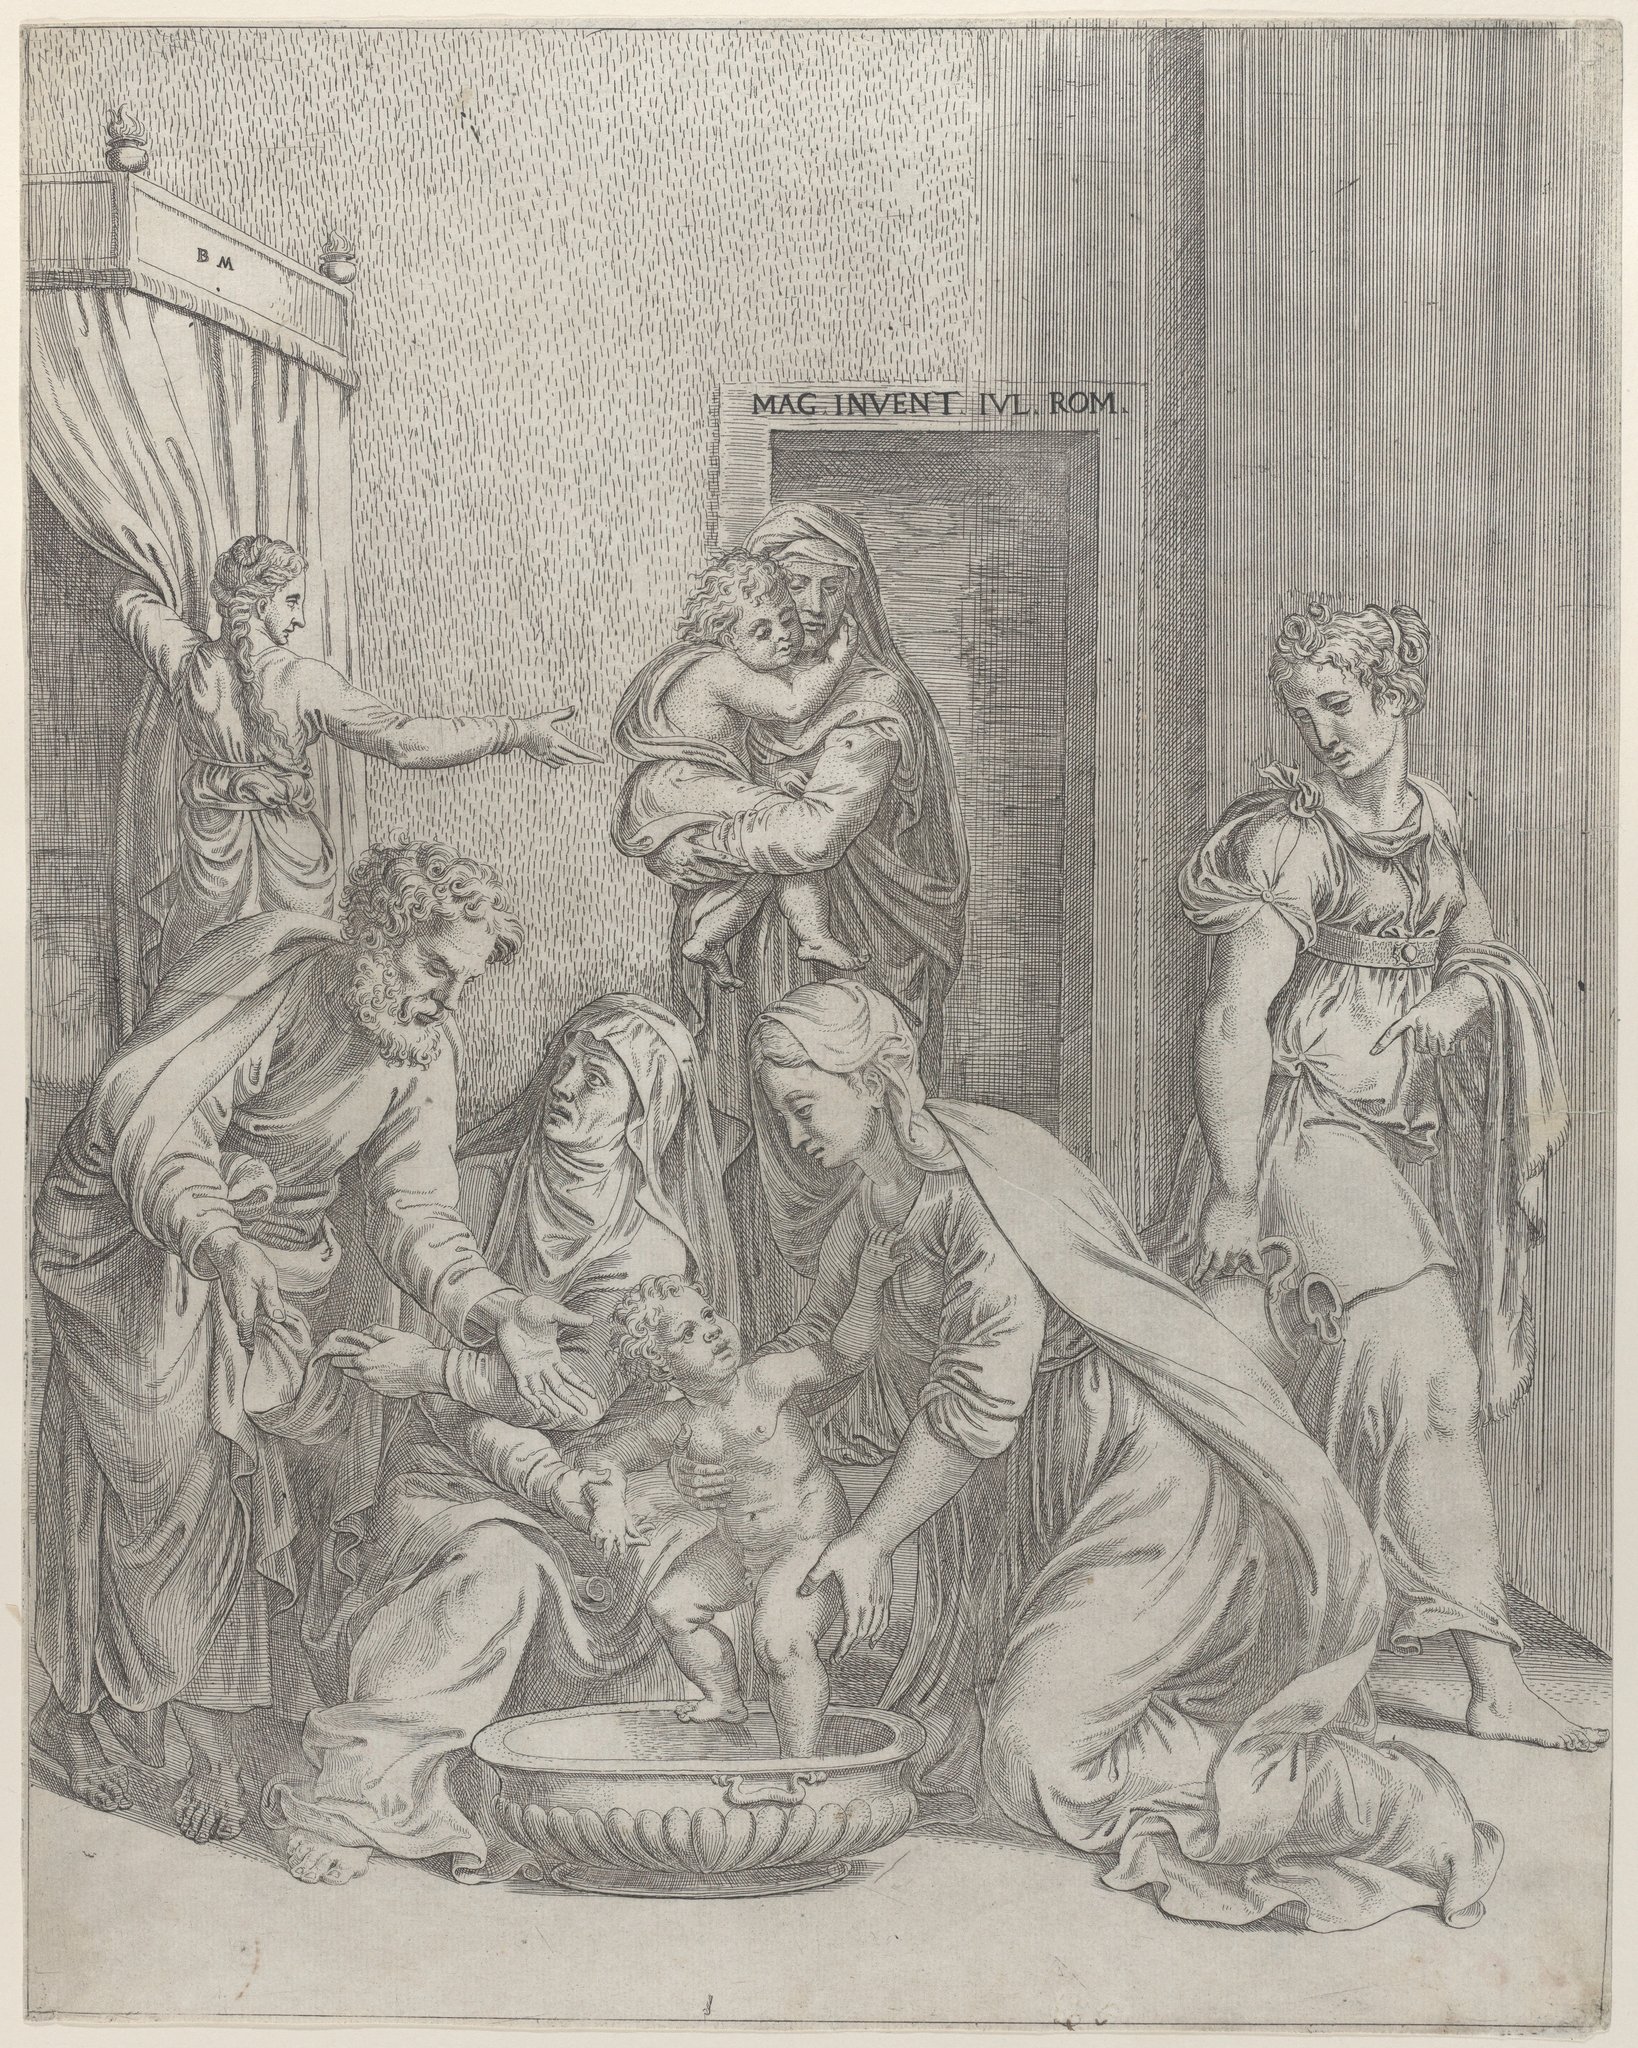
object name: print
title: The Holy Family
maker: battista angolo del moro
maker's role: artist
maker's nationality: italian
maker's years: 1515-1573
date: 1535-1573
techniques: etching